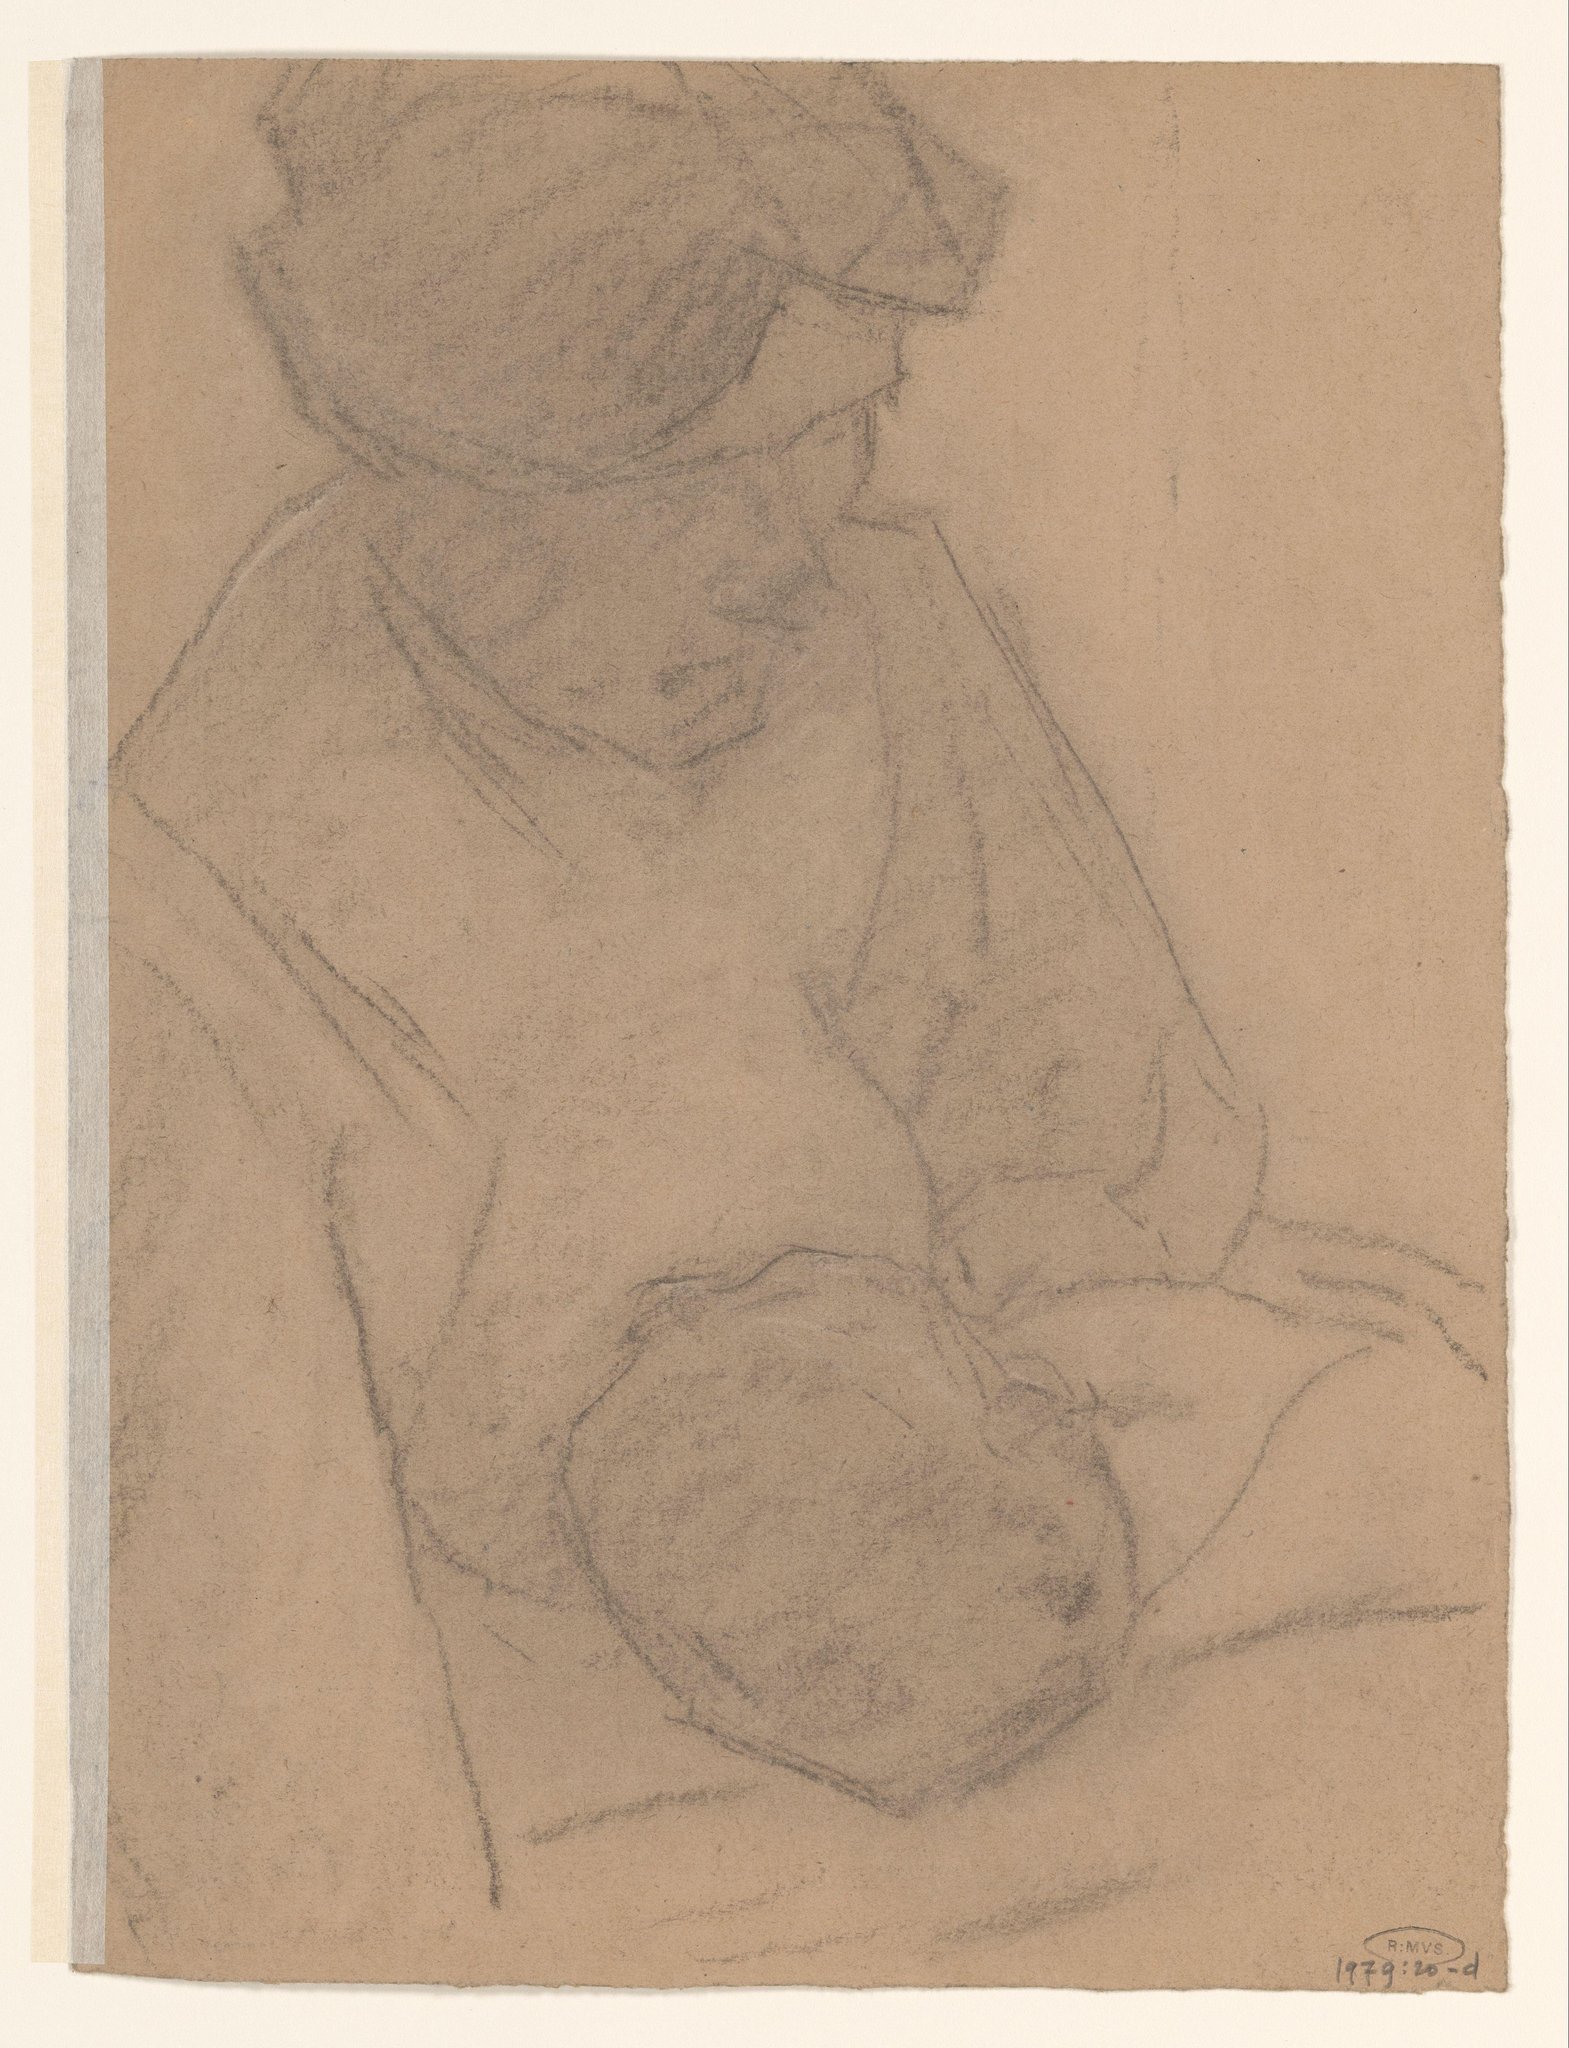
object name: drawing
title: Kind van Wilhelmus Johannes Steenhoff aan de borst van zijn moeder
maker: wilhelmus johannes steenhoff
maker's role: draughtsman, print maker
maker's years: 1863-1932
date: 1873-1932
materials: chalk, paper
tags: nursing, suckling, historical persons